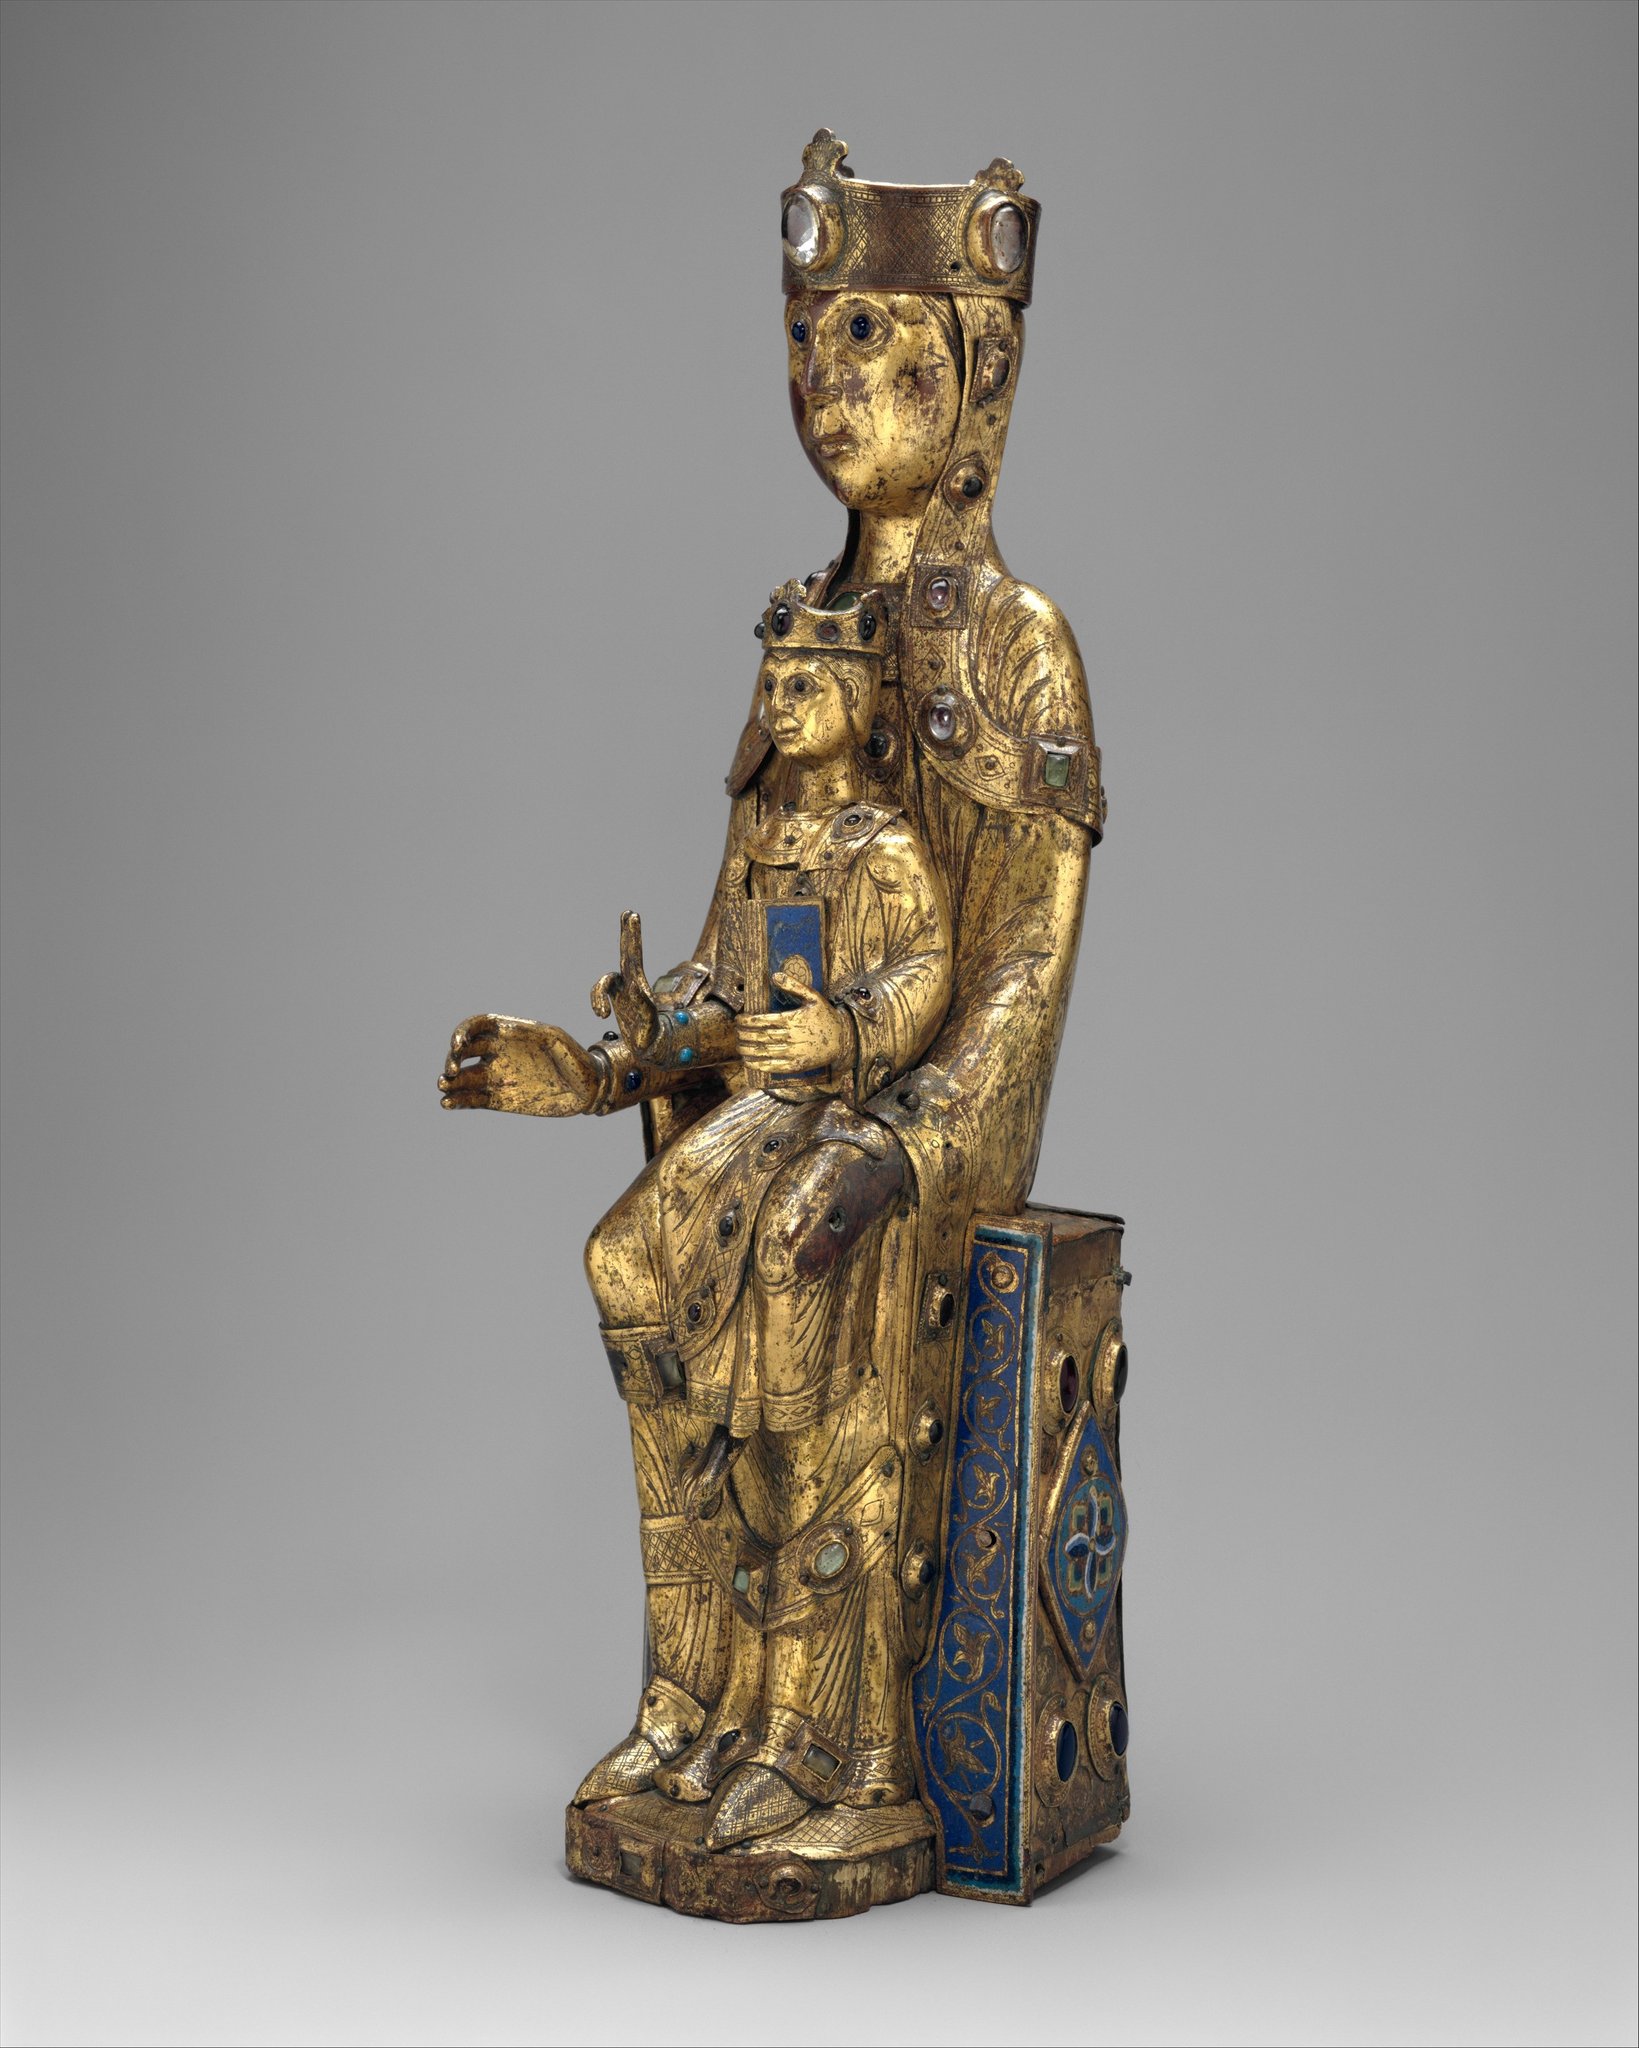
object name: statuette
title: Virgin and Child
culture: french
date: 1200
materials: copper, enamel, gilt, glass, wood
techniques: casting, enamel, chasing, engraving, forming, repoussé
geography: france